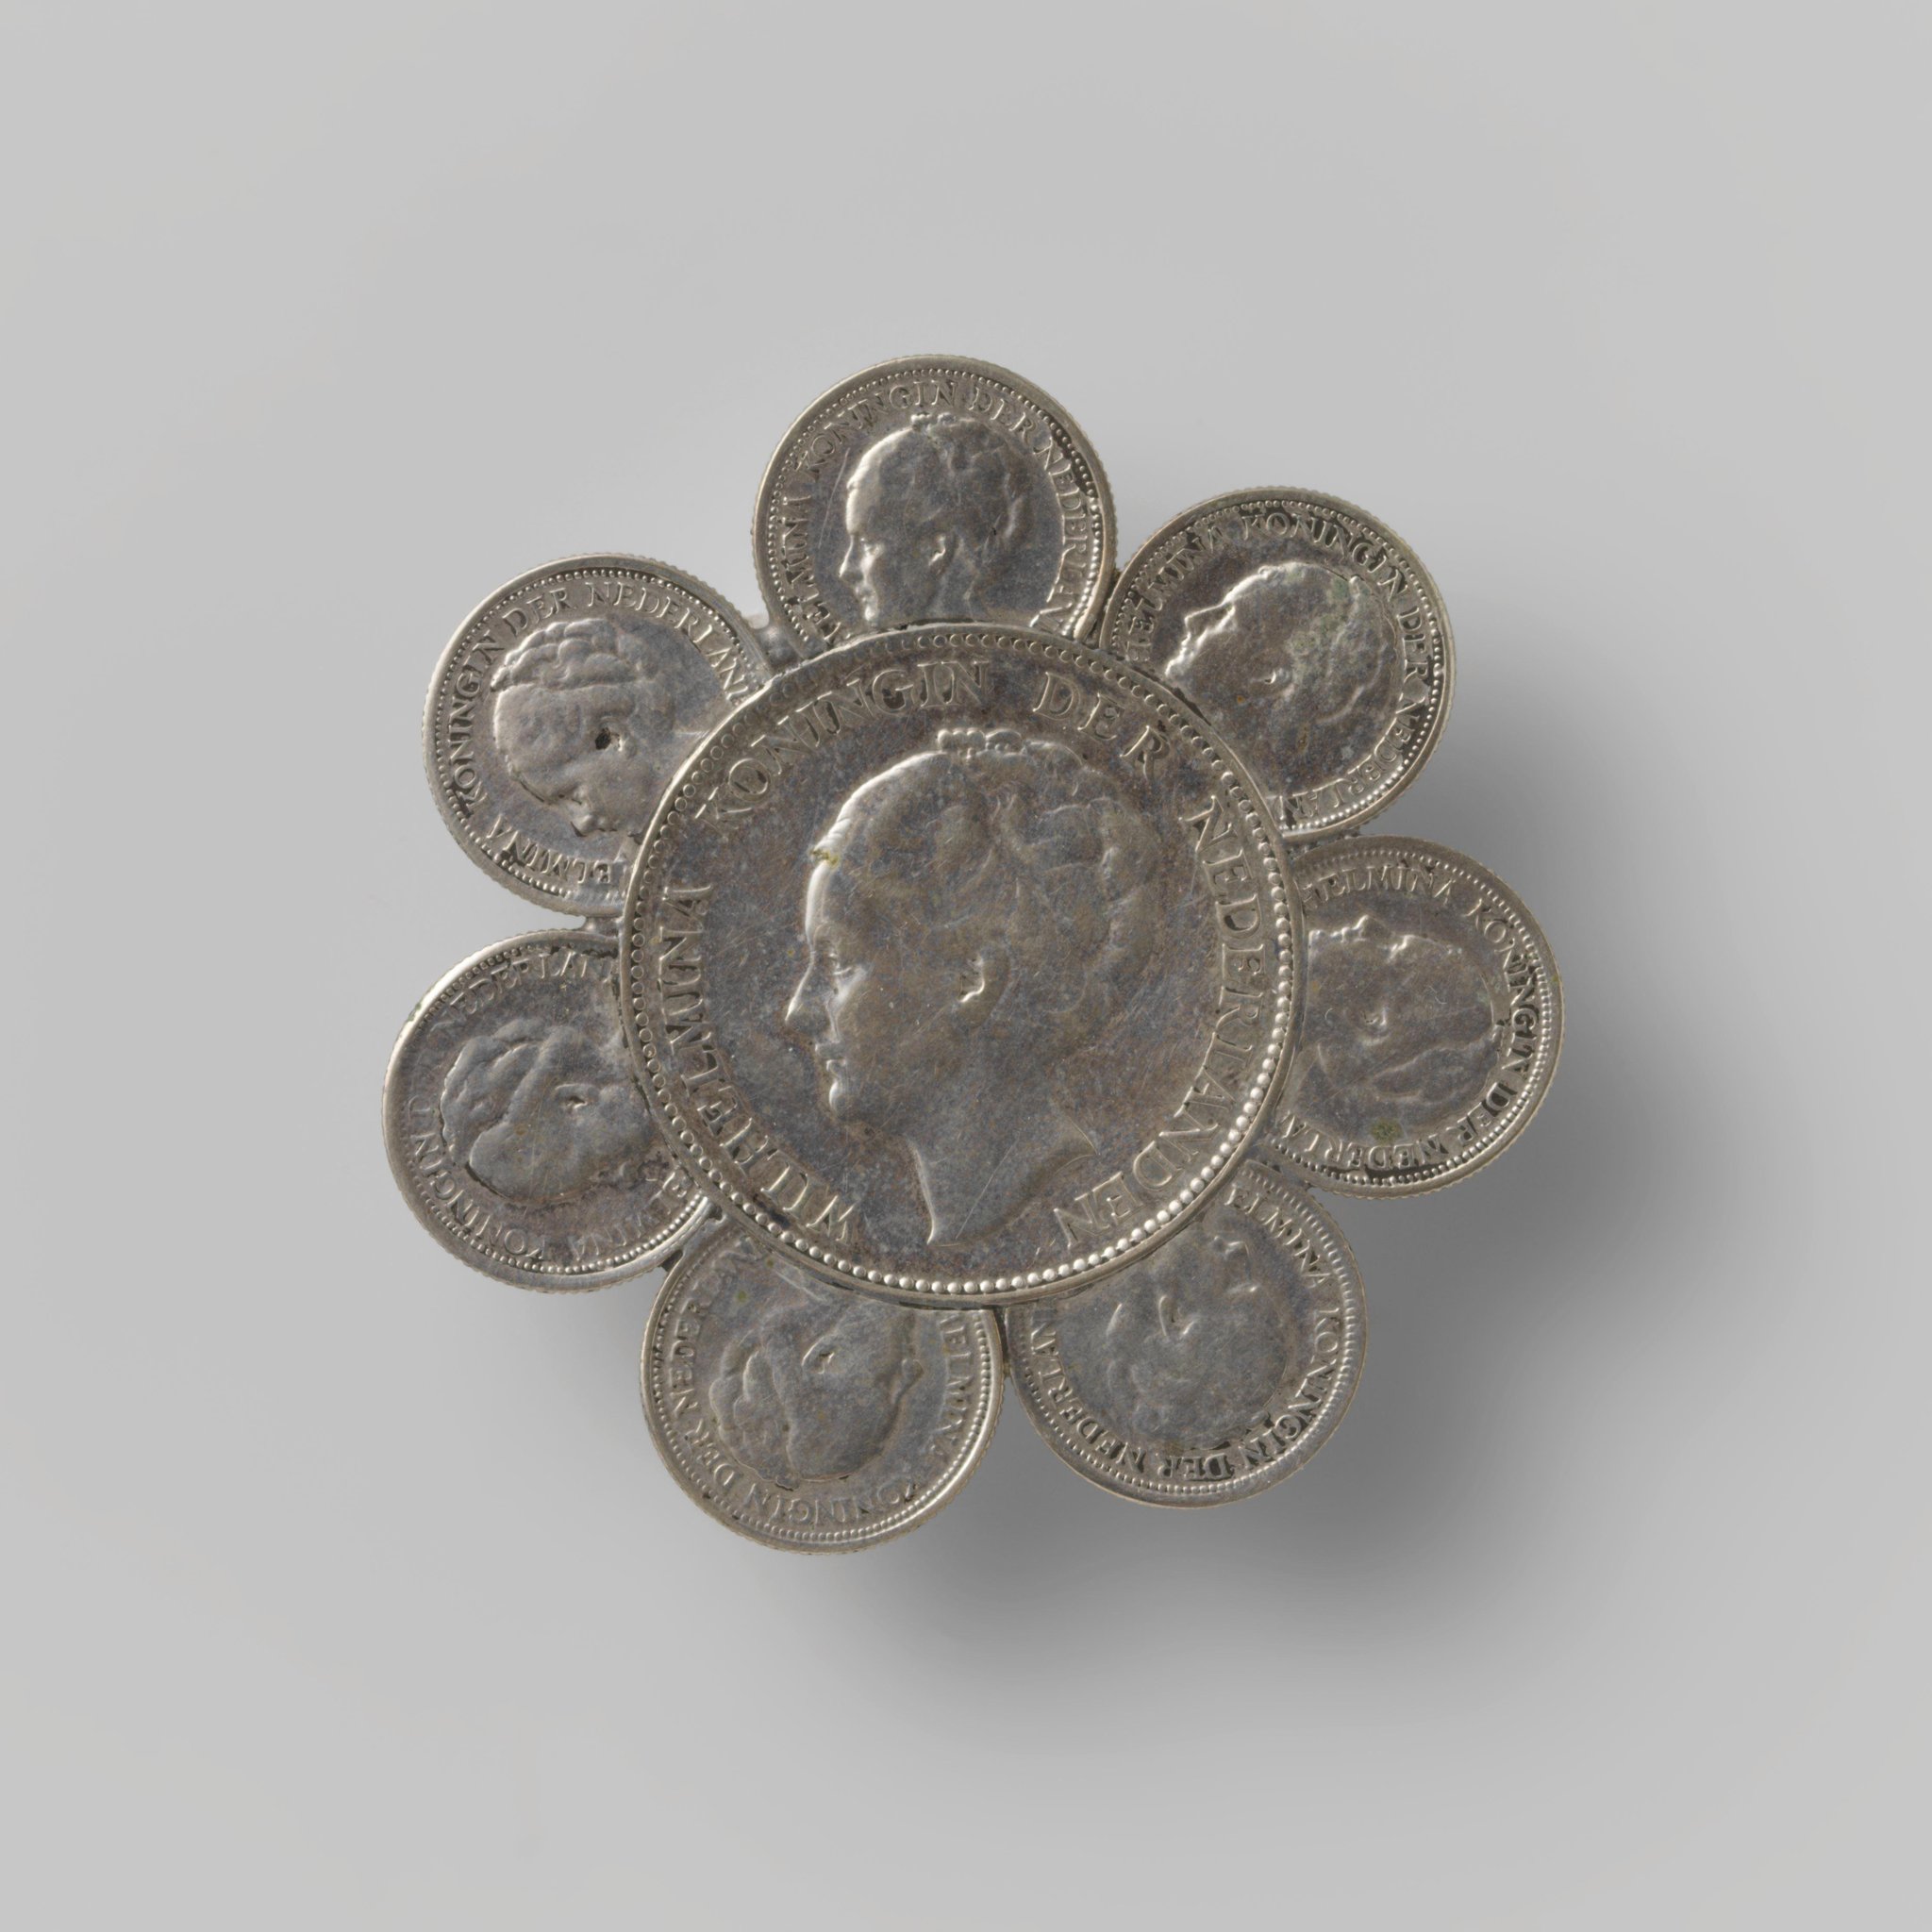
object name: brooch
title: Zilveren muntbroche in de vorm van een bloem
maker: Anonymous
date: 1940-1950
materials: metal, silver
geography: netherlands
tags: the hague, print maker, wilhelmina of the netherlands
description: Zilveren muntbroche in de vorm van een bloem met een sluiting van een veiligheidsspeld. Centraal een munt met de beeldenaar van Wilhelmina en daaromheen zeven kleinere munten (dubbeltjes) met eveneens de beeldenaar van Wilhelmina.